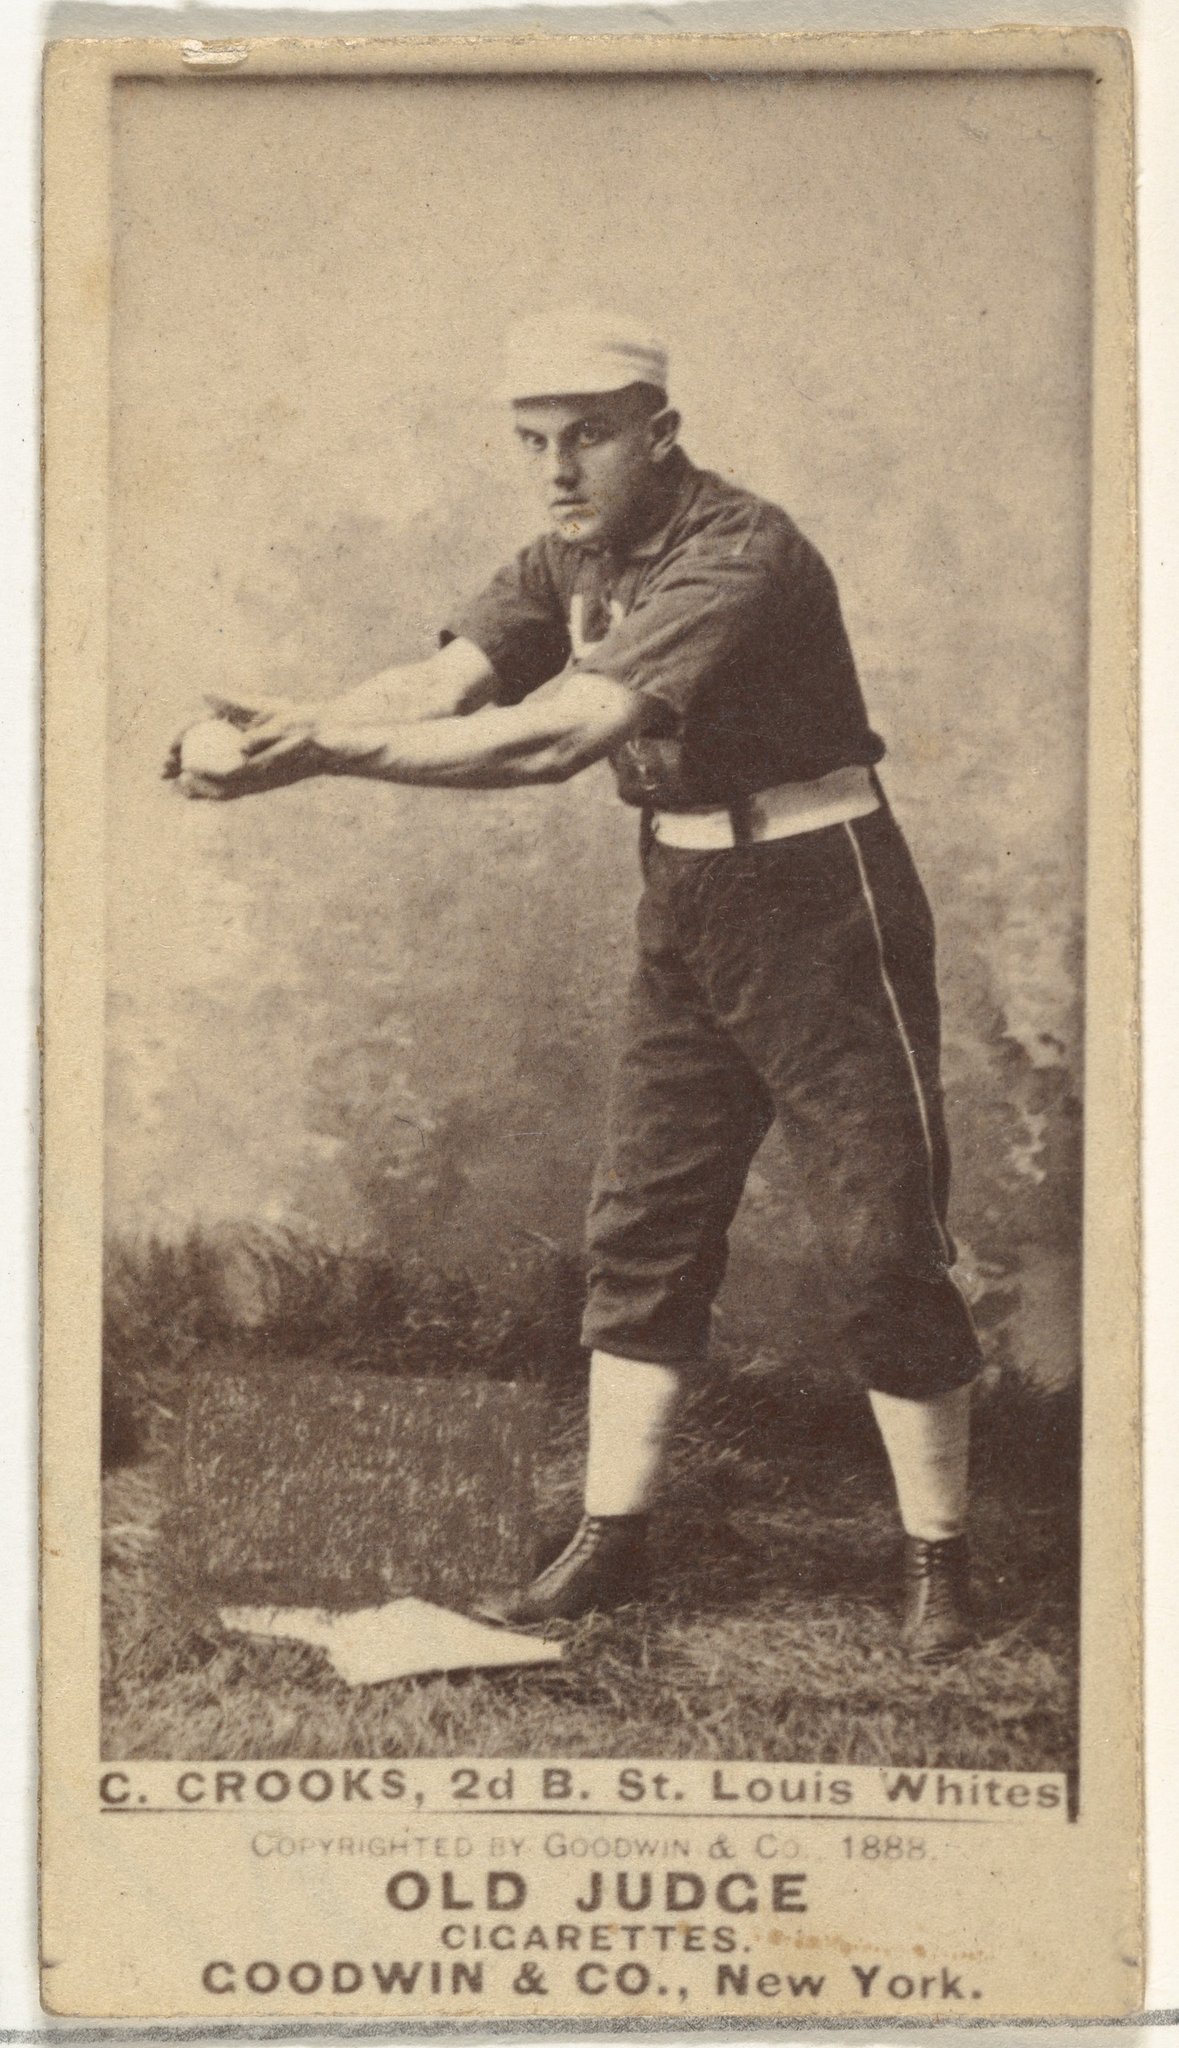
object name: baseball card, photograph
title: Crooks, 2nd Base, St. Louis Whites, from the Old Judge series (N172) for Old Judge Cigarettes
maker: goodwin & company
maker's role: publisher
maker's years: 1850-1950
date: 1888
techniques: albumen silver print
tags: men,portraits,baseball,athletes